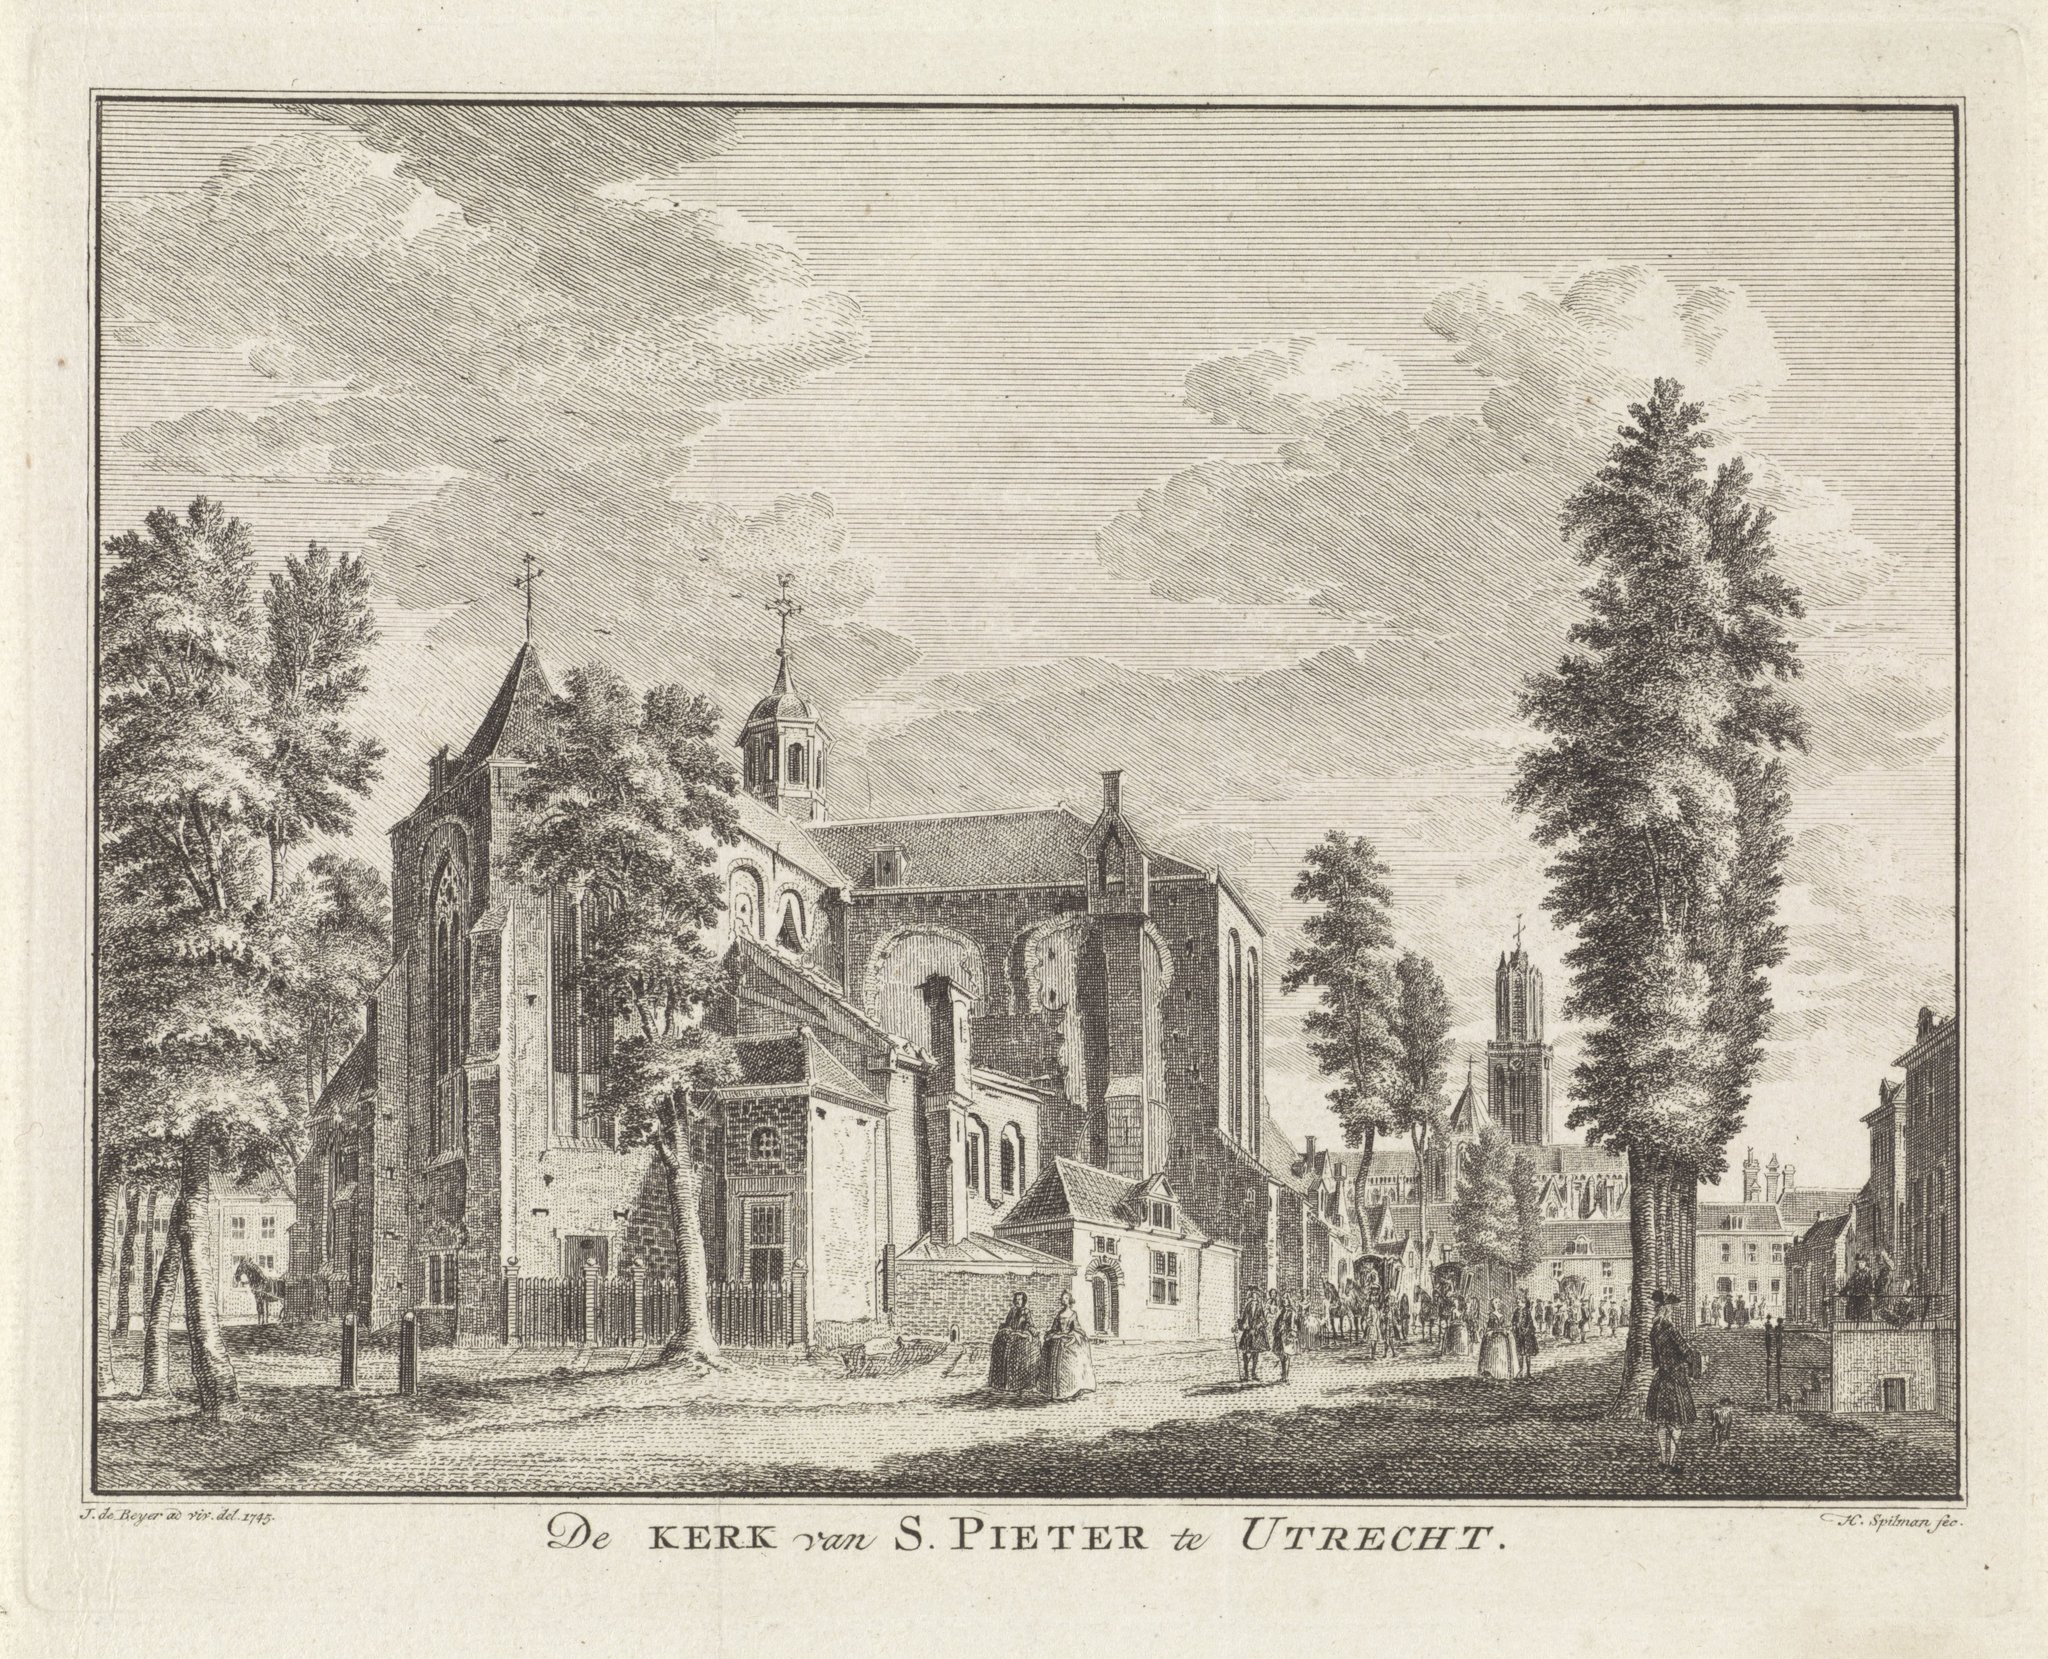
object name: print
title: De Kerk van S.Pieter te Utrecht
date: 1745-1758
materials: paper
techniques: etching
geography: amsterdam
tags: square, place, circus, etc., church (exterior)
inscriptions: collector's mark: Lugt 2228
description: Prent ook gebruikt in: Tegenwoordige staat der Vereenigde Nederlanden, elfde deel, behelzende eene beschryving van de provincie van Utrecht. Met landkaarten, plans der steden en printverbeeldingen versierd / Hedendaagsche historie, of tegenwoordige staat van alle volkeren; XXI. deel (…). Amsterdam: Isaak Tirion, 1758, tussen p. 370 en p. 371.